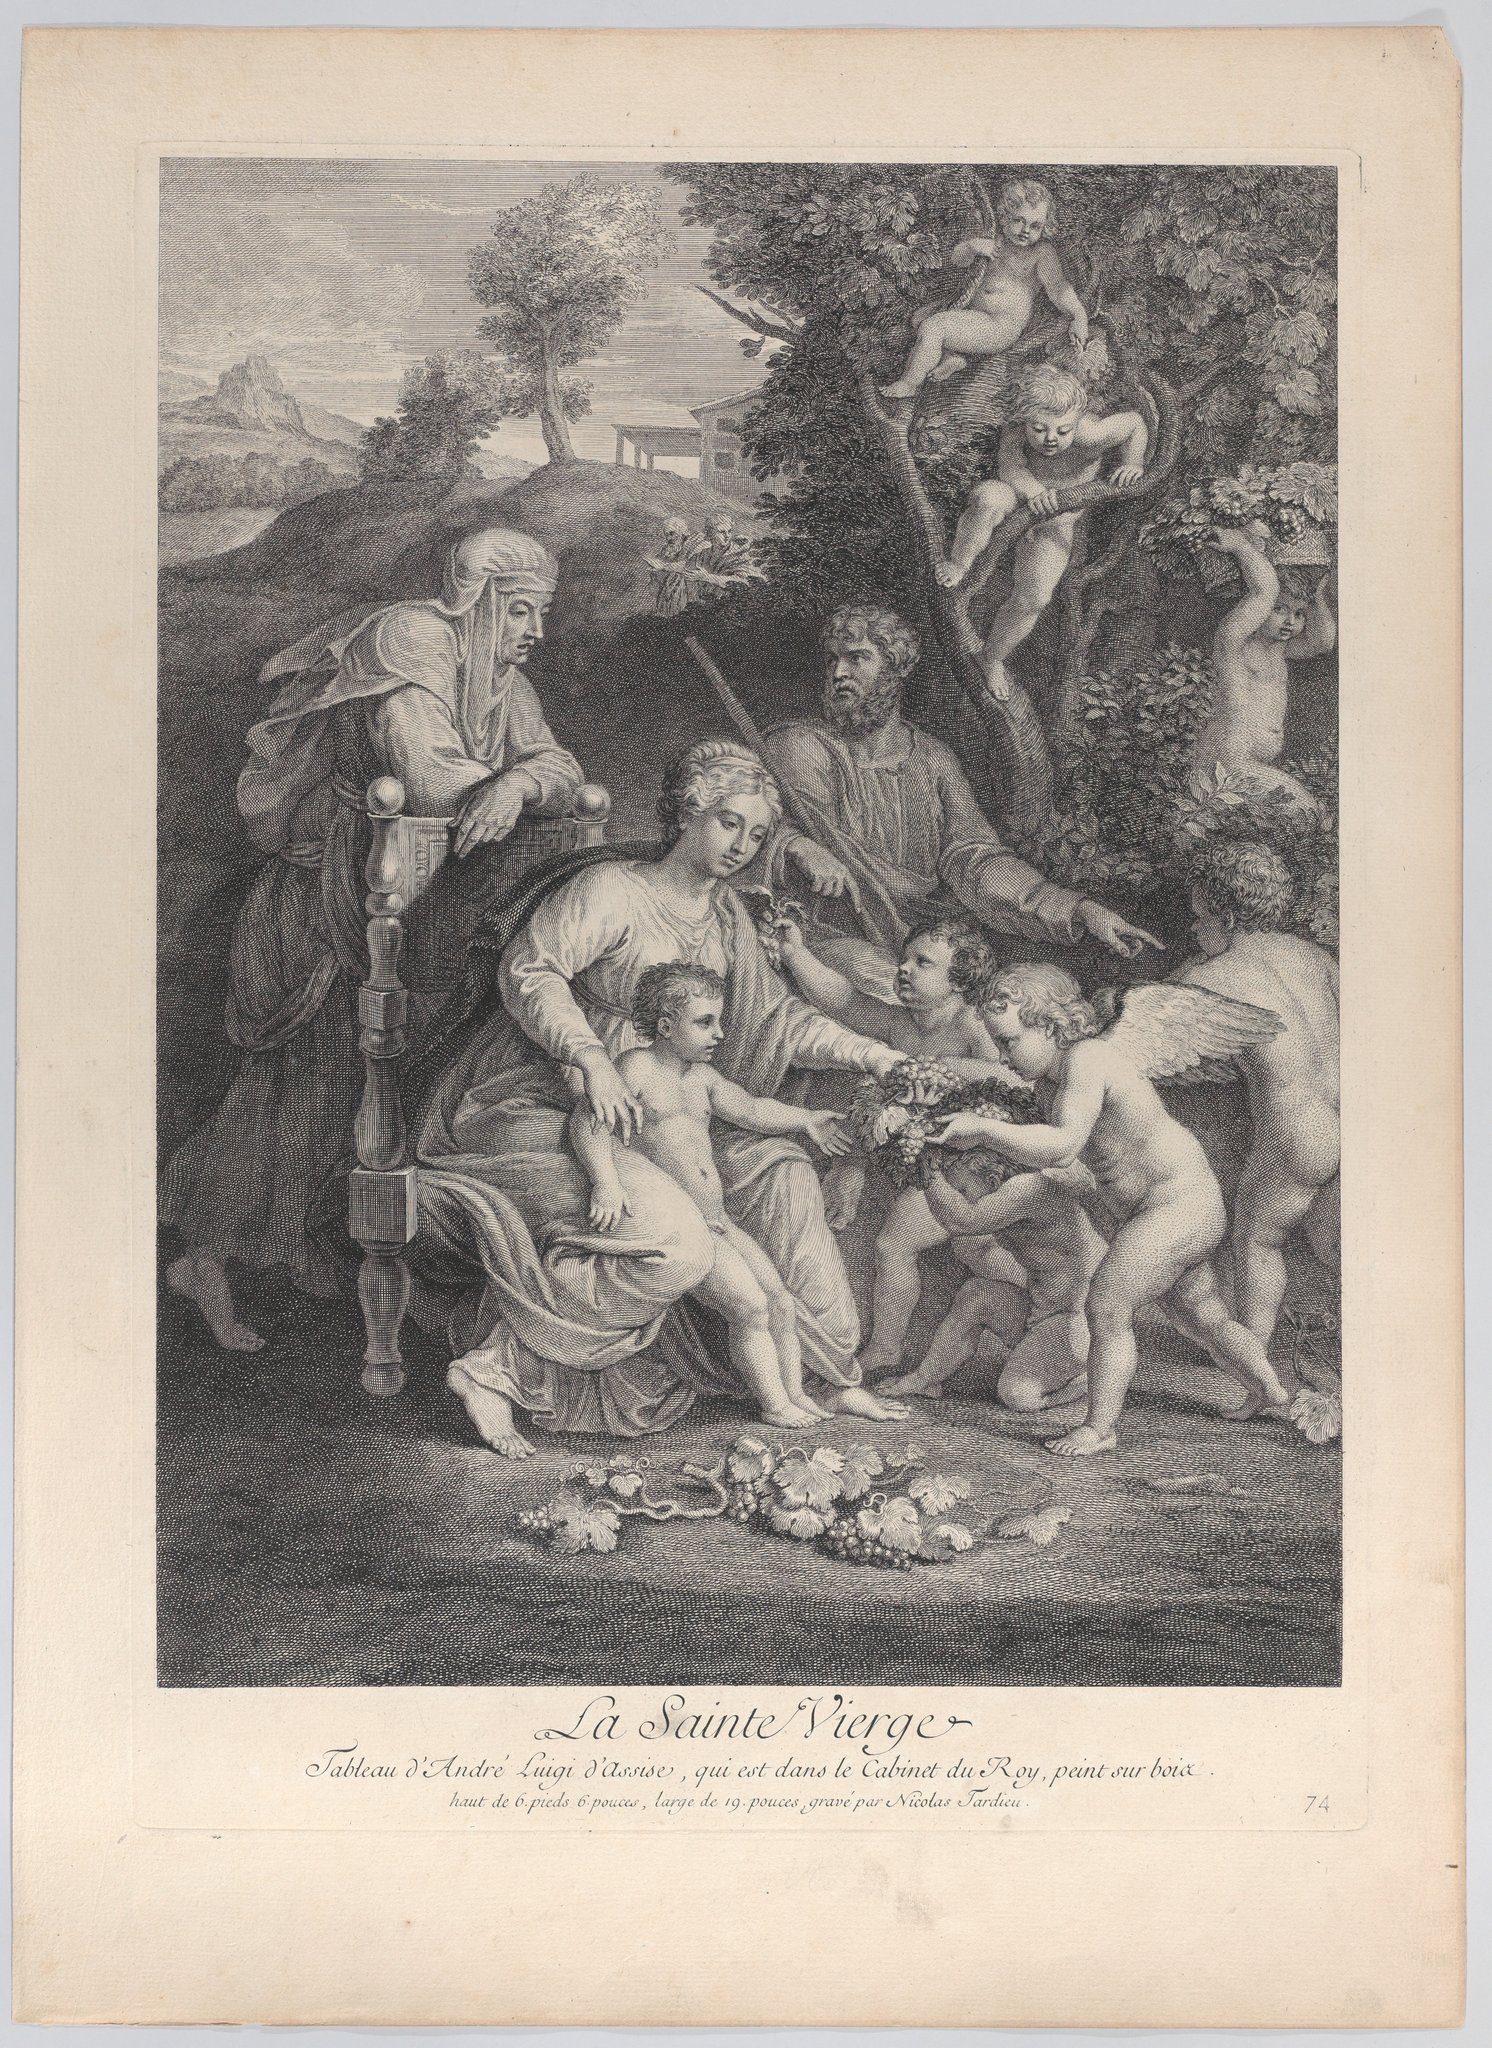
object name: print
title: The Holy Family with Saint Elizabeth and angels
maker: nicolas henry tardieu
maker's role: artist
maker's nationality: french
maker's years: 1674-1749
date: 1729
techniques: engraving, etching